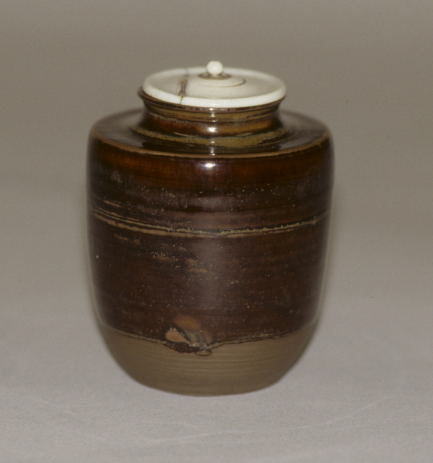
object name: tea jar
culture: japanese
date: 1700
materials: clay, glaze